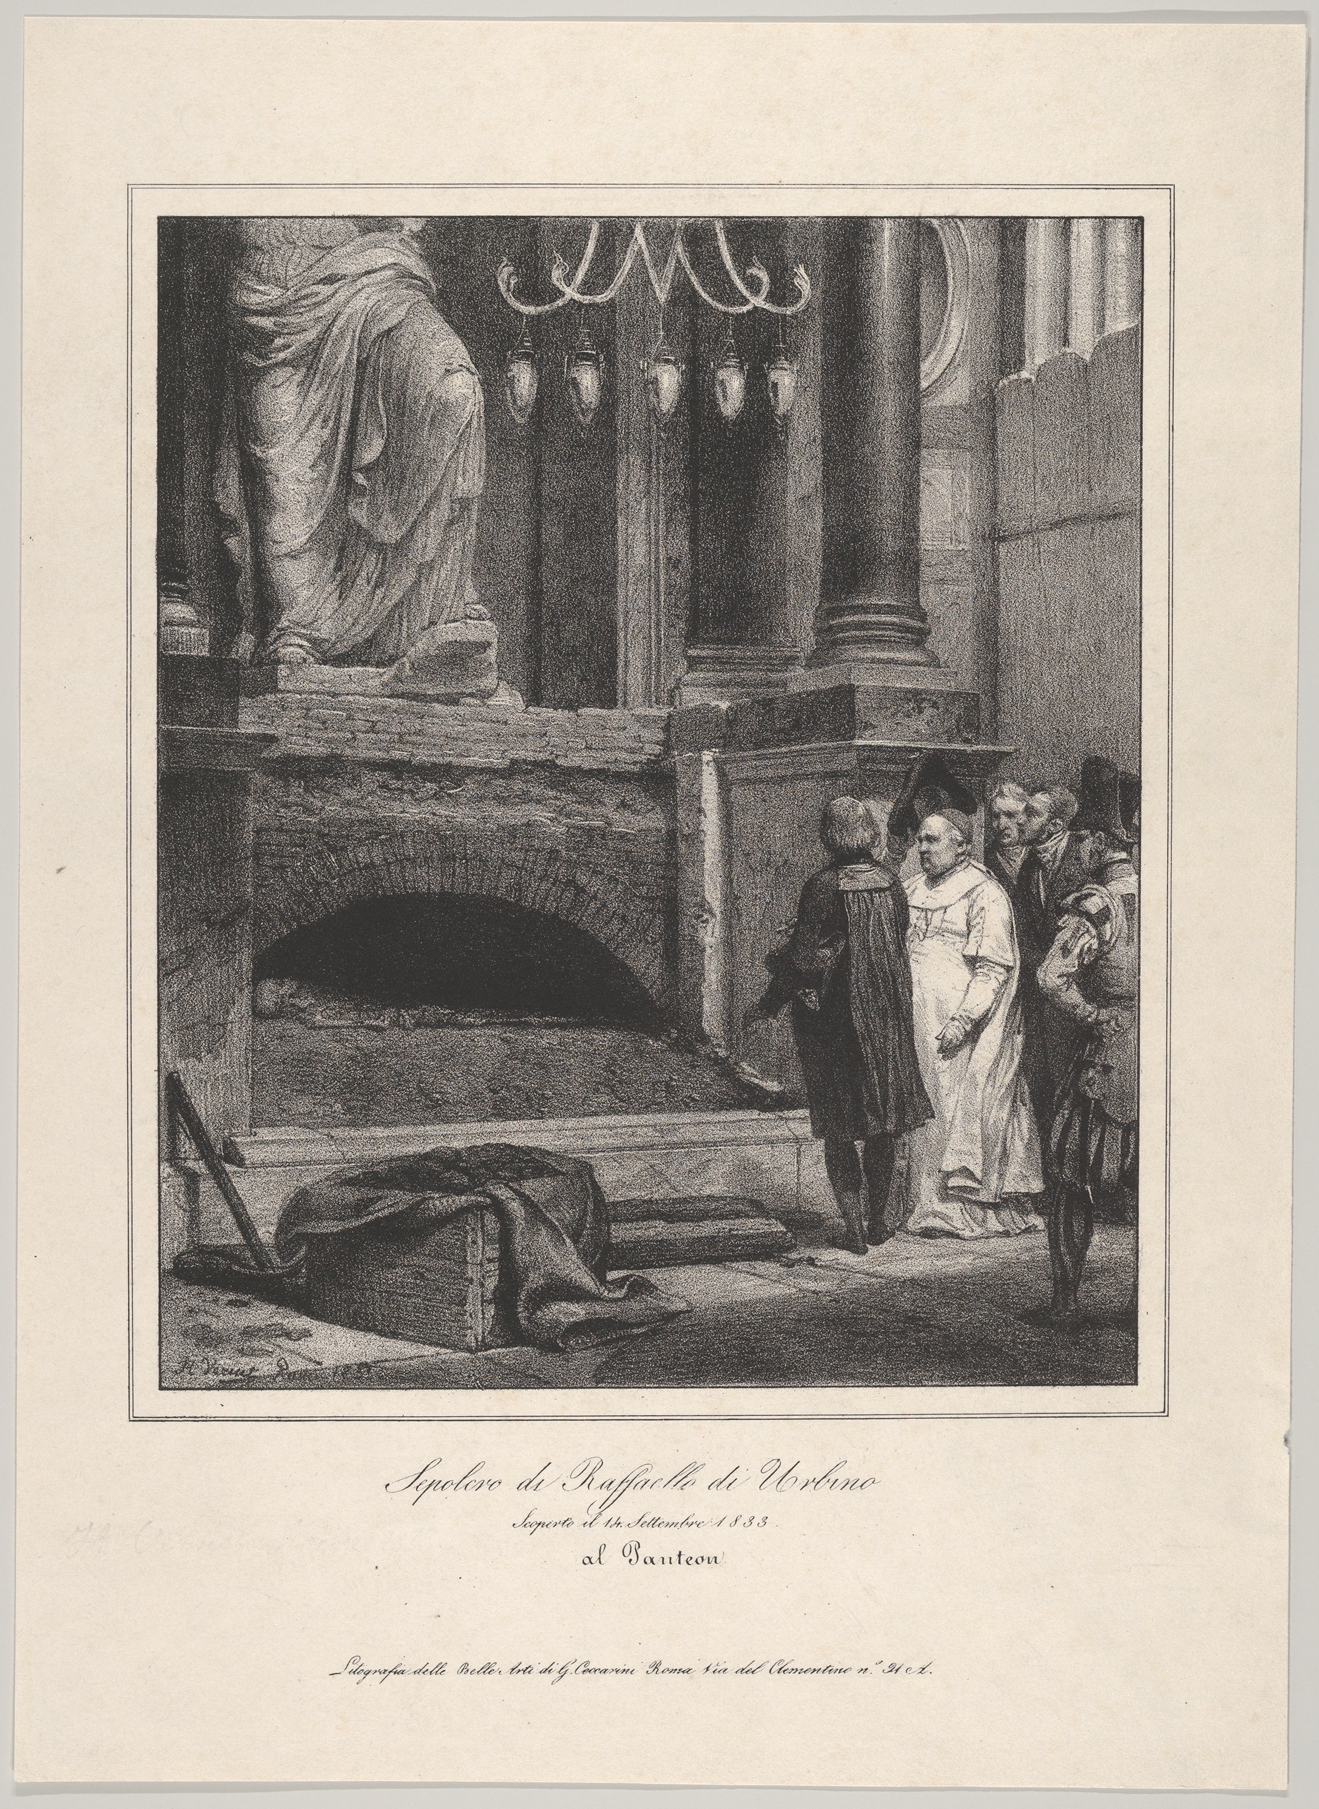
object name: print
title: The Tomb of Raphael, Opened September 14, 1833, Pantheon, Rome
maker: horace vernet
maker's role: artist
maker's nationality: french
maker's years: 1789-1863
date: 1833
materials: paper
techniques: lithograph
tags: tombs,men